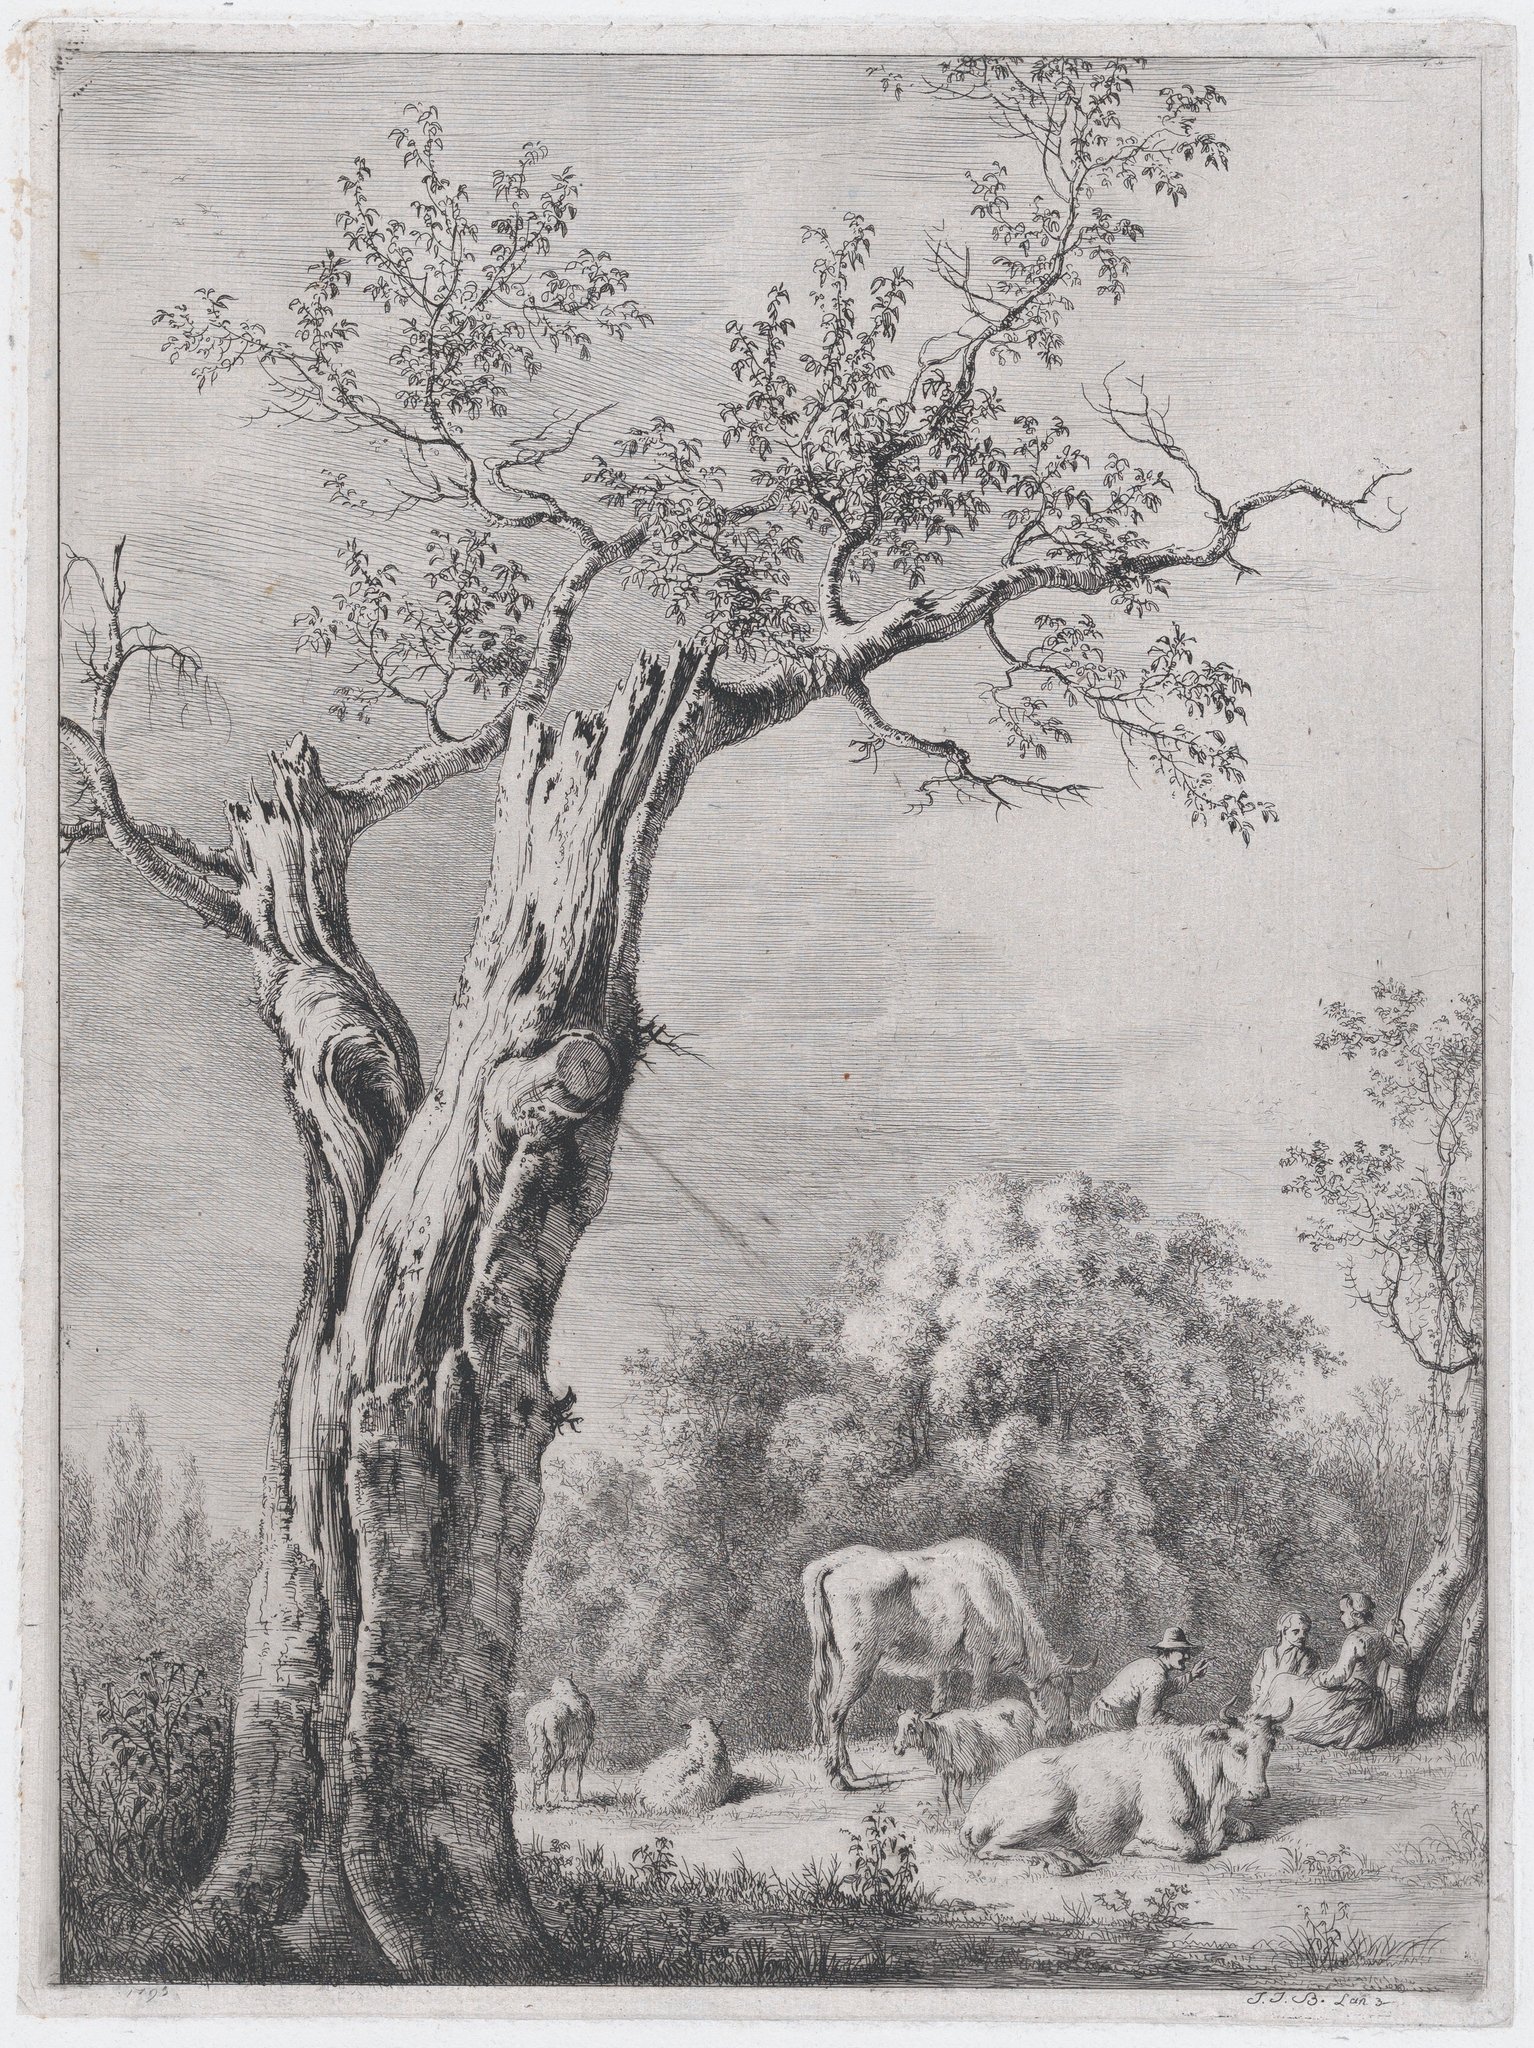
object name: print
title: Spring, after a Drawing Made at Saint-Chamond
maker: jean jacques de boissieu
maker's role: artist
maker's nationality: french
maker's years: 1736-1810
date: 1795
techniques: etching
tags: men,women,cows,trees,spring